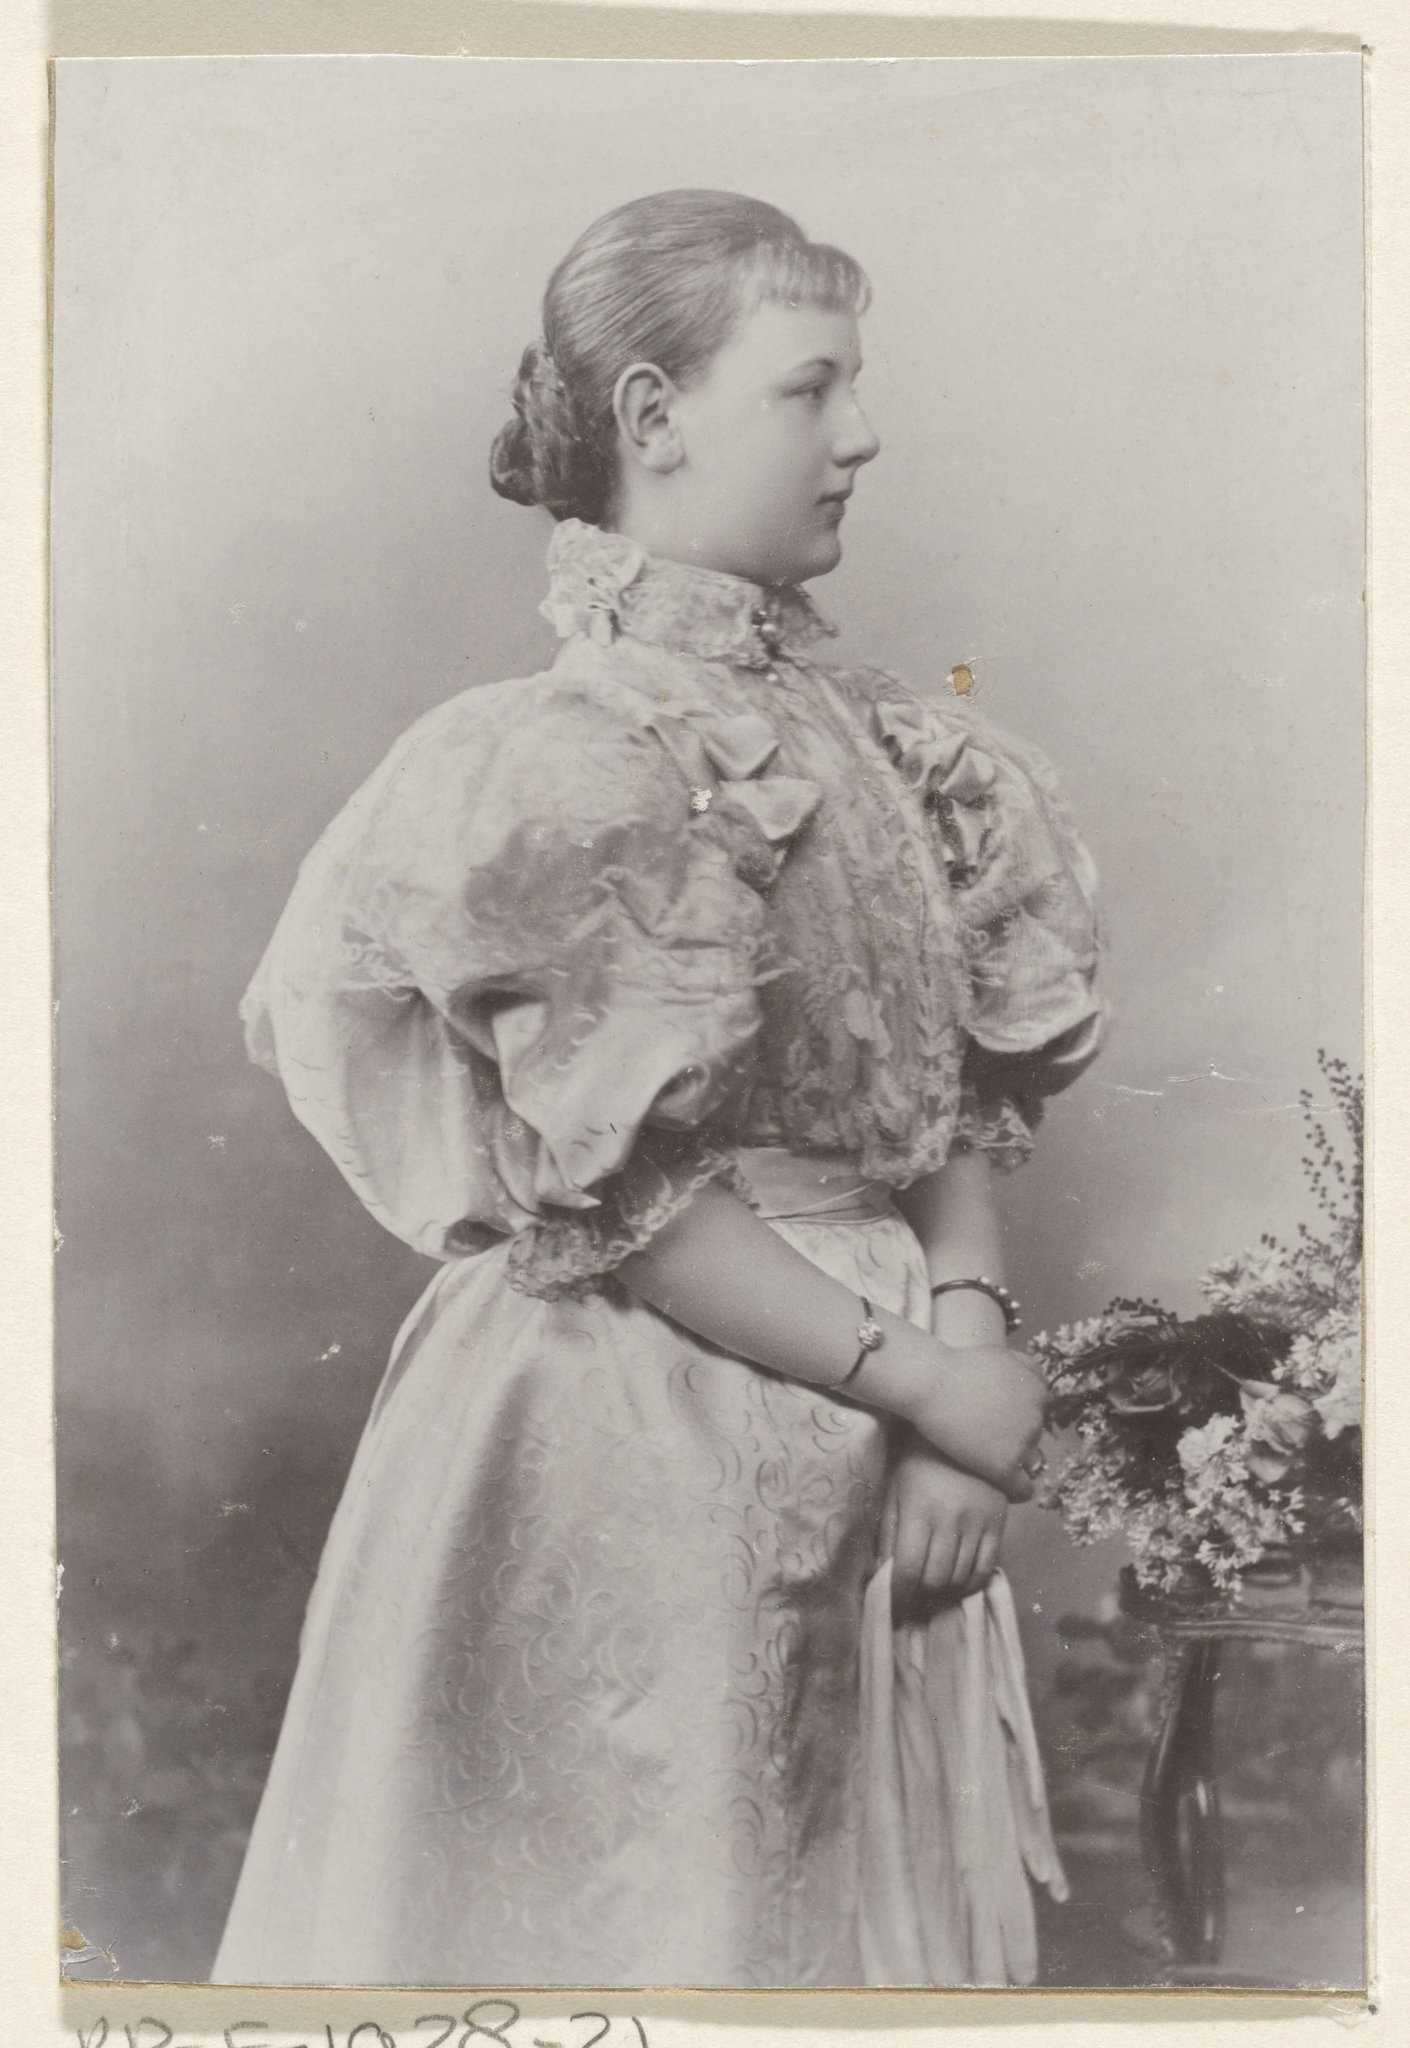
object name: photograph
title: Portret van Wilhelmina, koningin der Nederlanden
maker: richard kameke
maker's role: fotograaf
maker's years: 1847-1898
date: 1896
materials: photographic support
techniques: daylight paper print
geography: the hague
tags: print maker, wilhelmina of the netherlands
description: De hier vermelde titel verwijst naar de hoogst verkregen titel van de geportretteerde, niet per se naar de titel die de geportretteerde op deze voorstelling draagt.